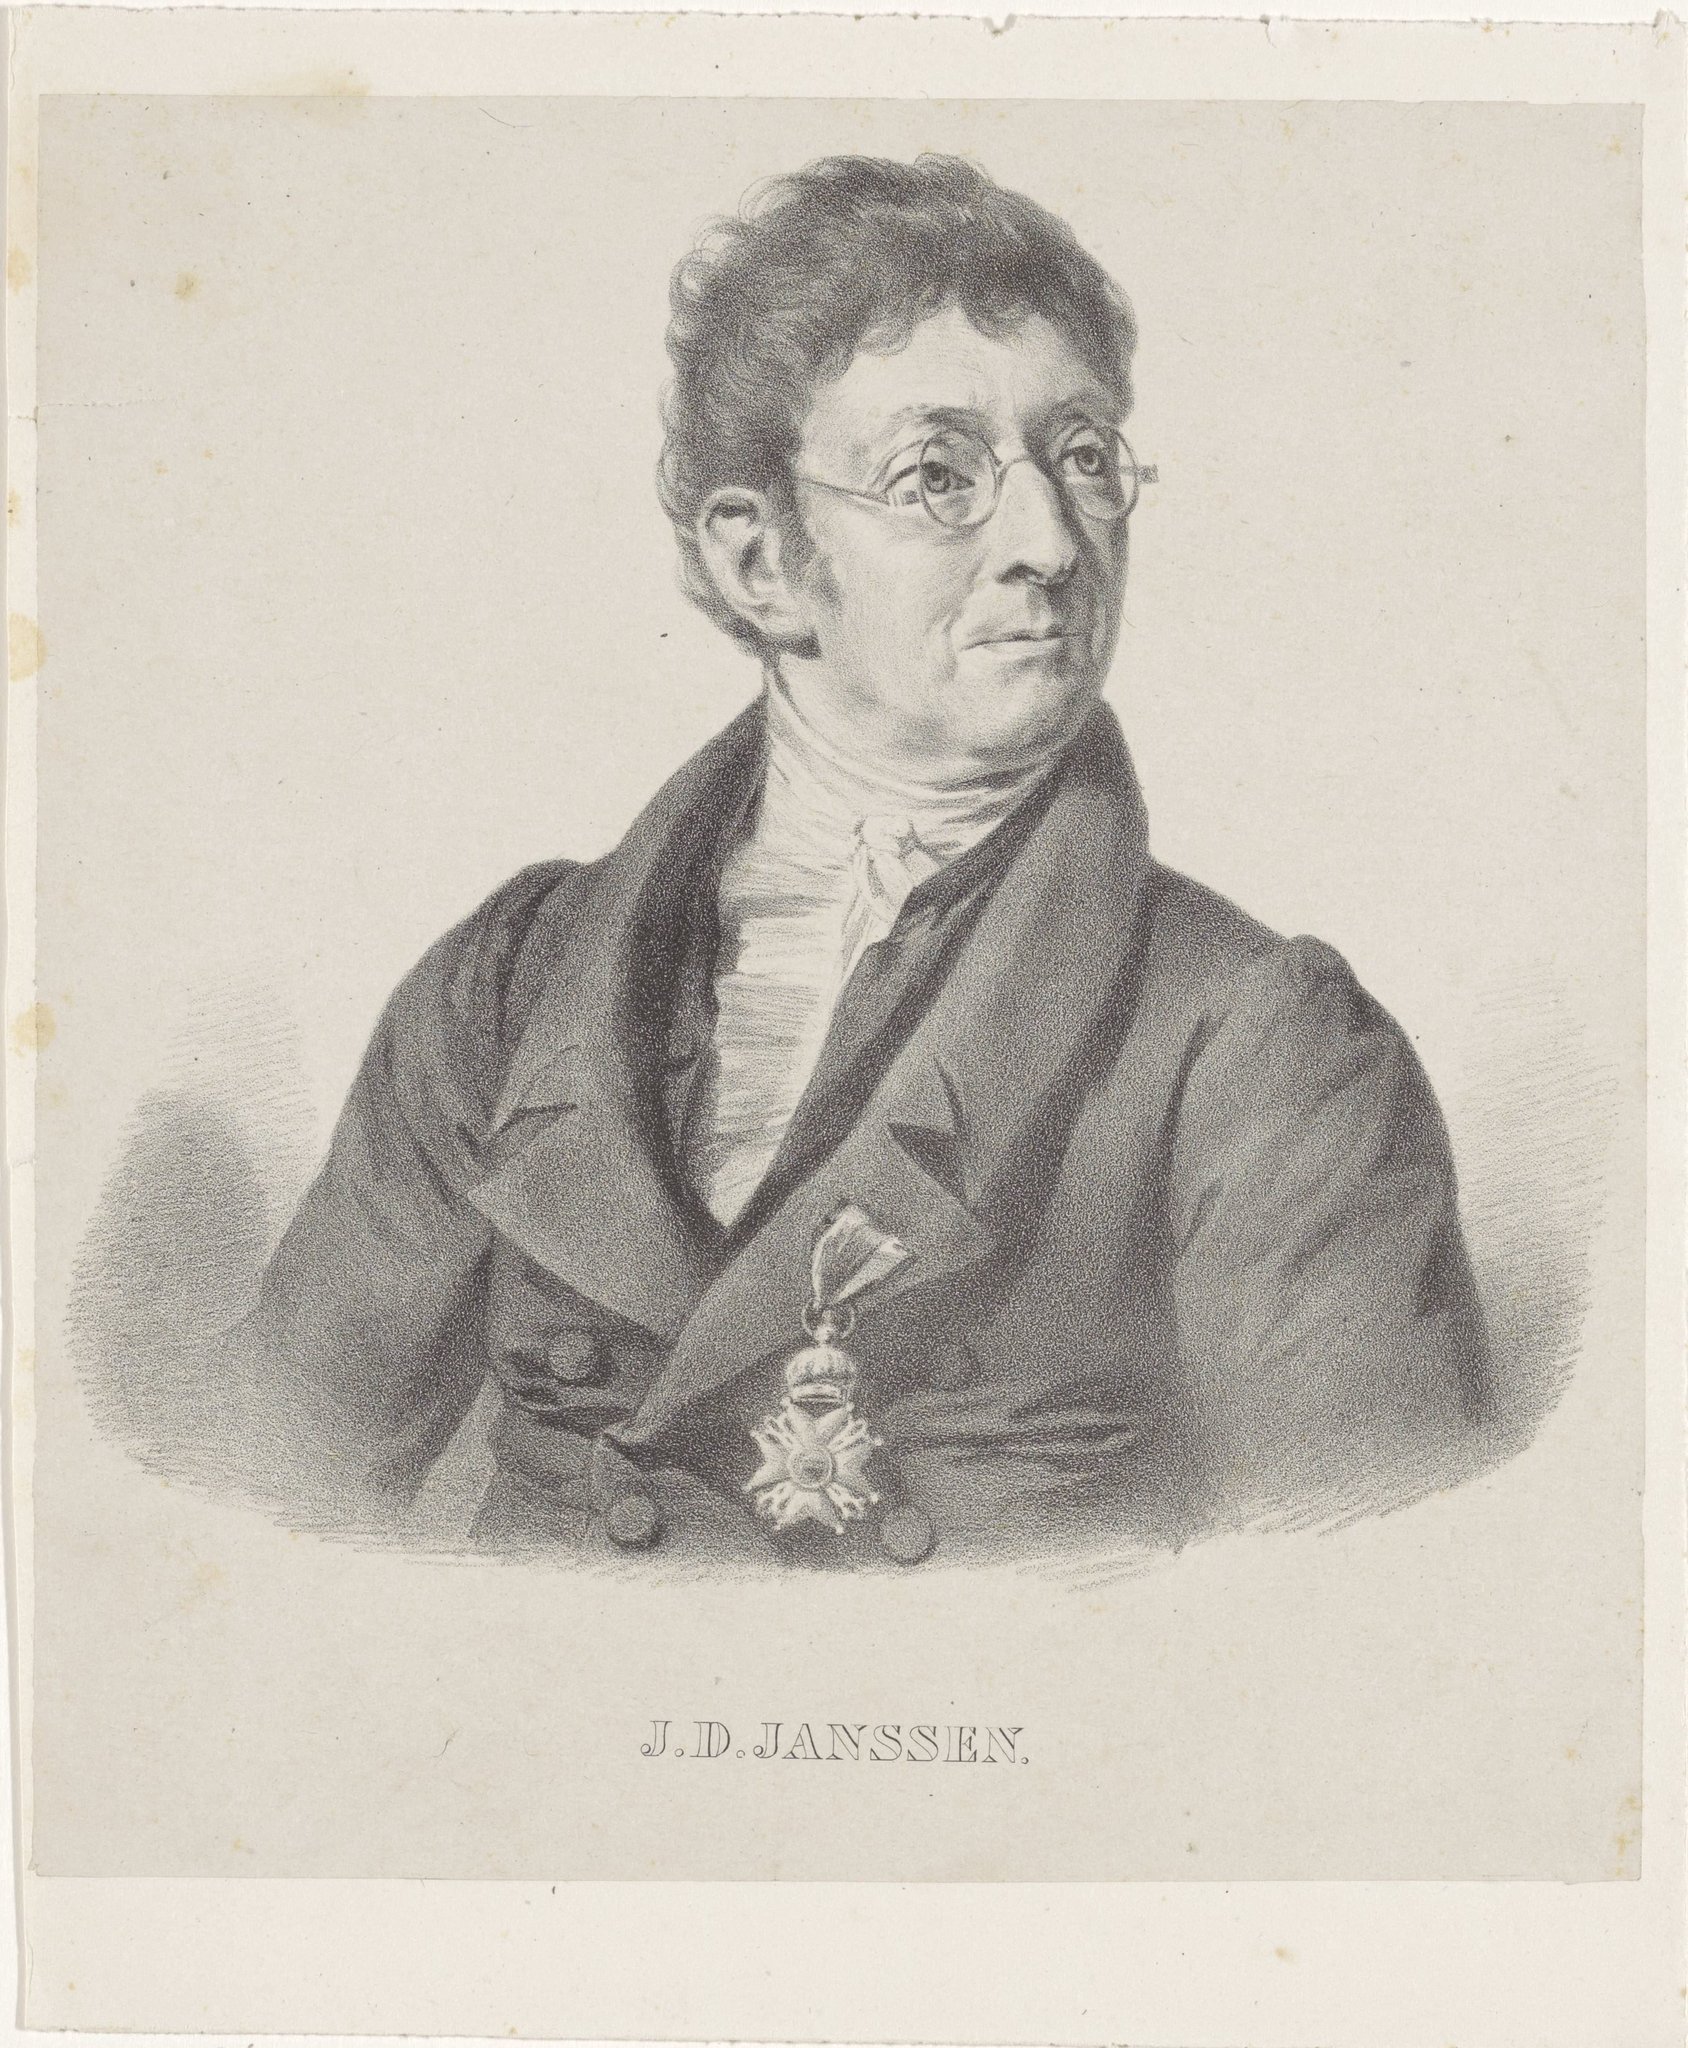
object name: print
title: Portret van J.D. Janssen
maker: herman antonie de bloeme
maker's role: painter, print maker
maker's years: 1802-1867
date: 1812-1867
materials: paper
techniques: lithograph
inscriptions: collector's mark: Lugt 2228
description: De geportretteerde kijkt naar rechts en draagt een ridderorde op de revers van zijn jas. Onder het portret zijn naam.